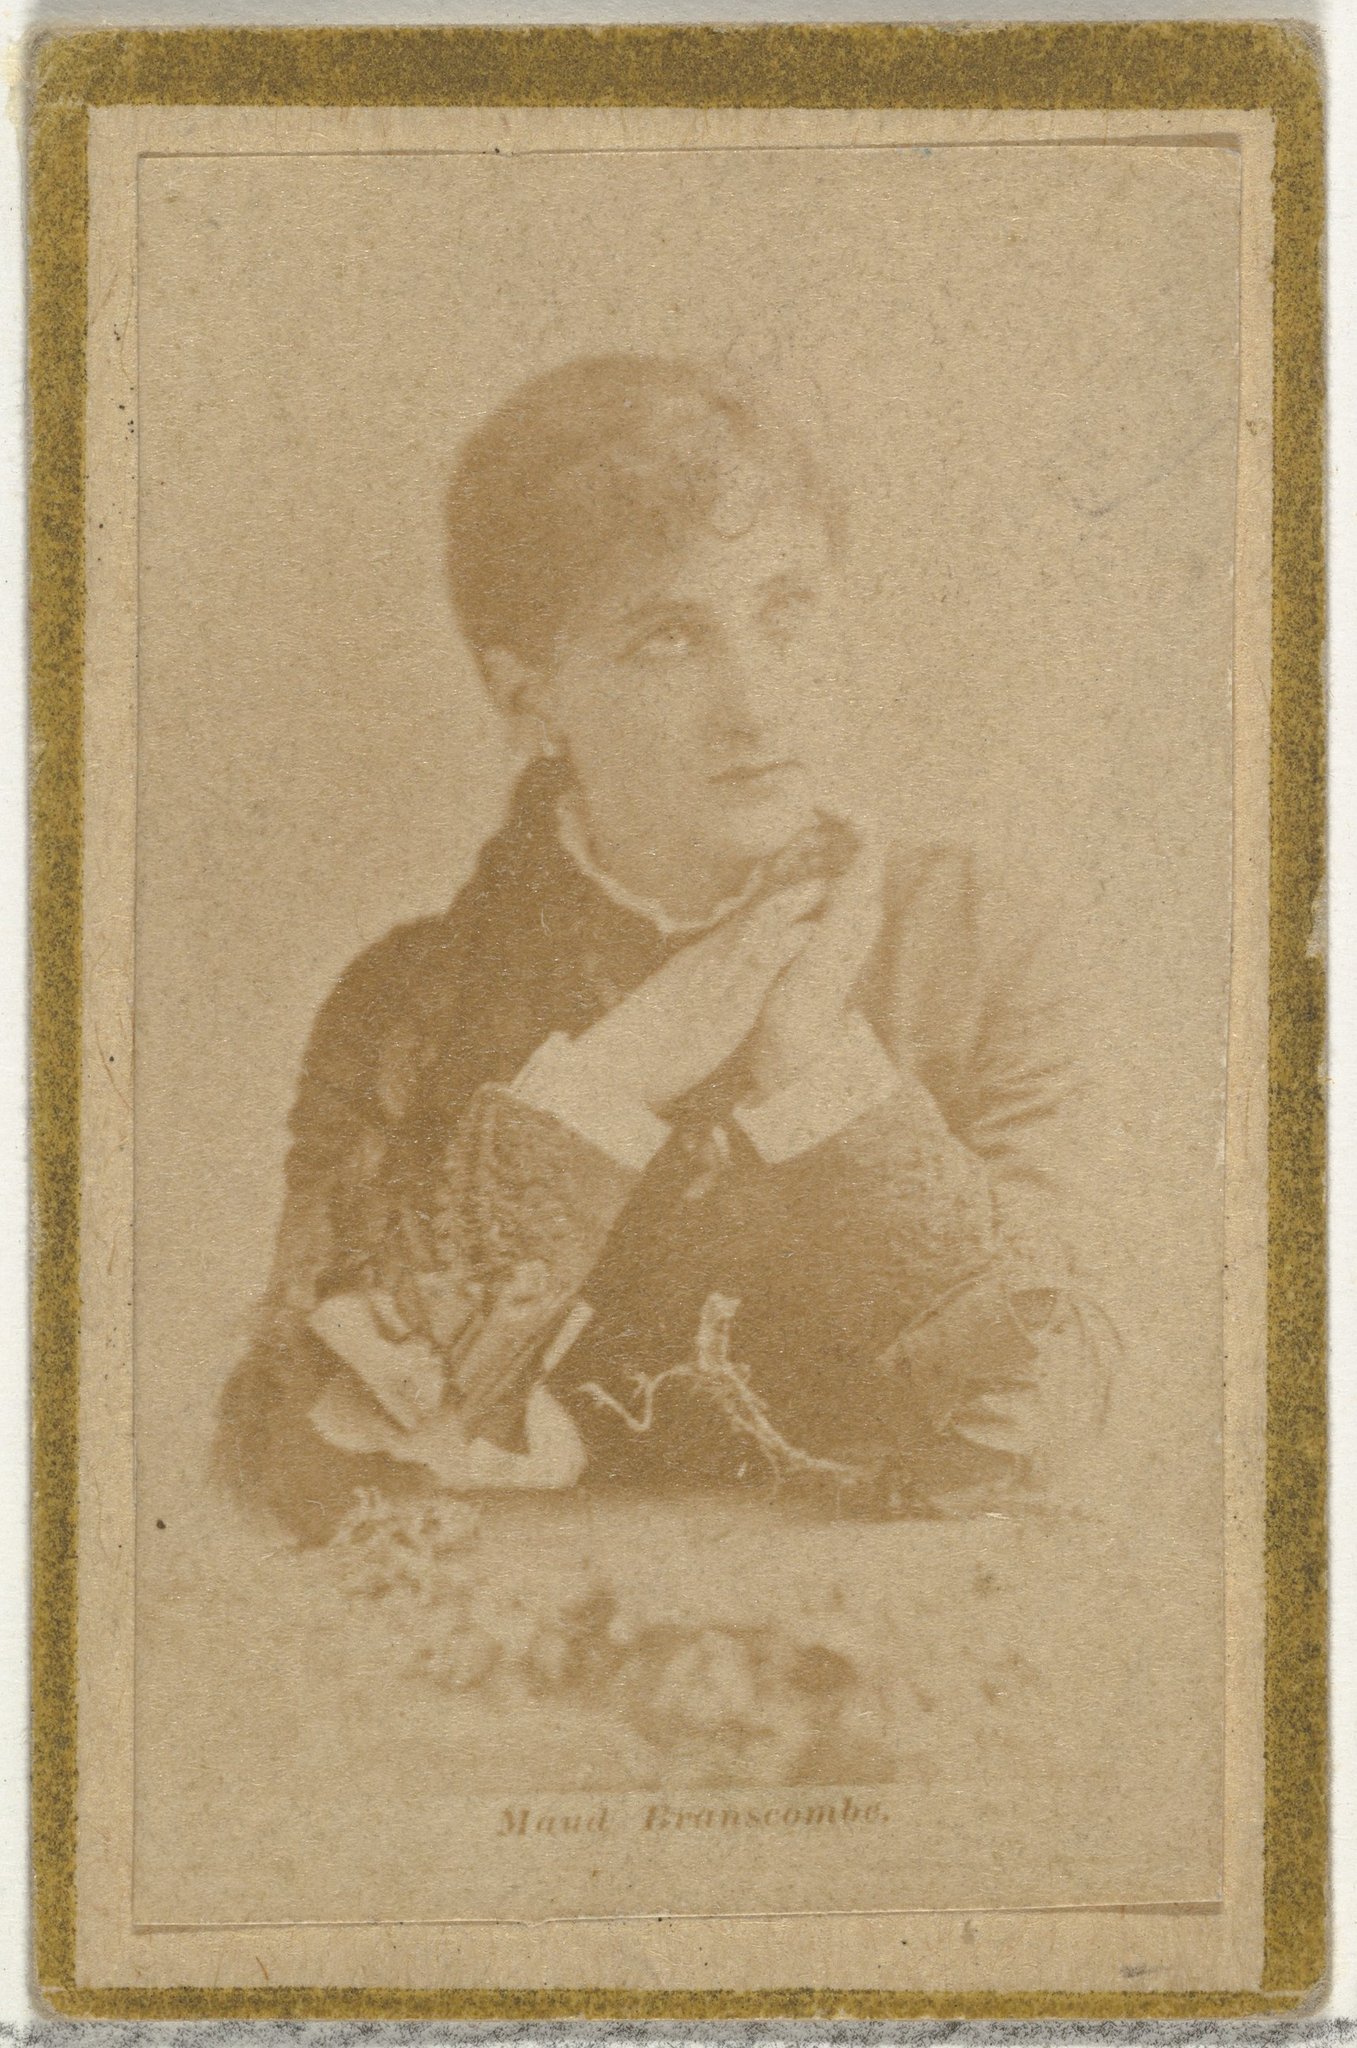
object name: photograph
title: Maud Branscombe, from the Actresses and Celebrities series (N60, Type 2) promoting Little Beauties Cigarettes for Allen & Ginter brand tobacco products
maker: allen & ginter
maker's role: publisher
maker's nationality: american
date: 1887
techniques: albumen silver print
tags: portraits,women,actresses